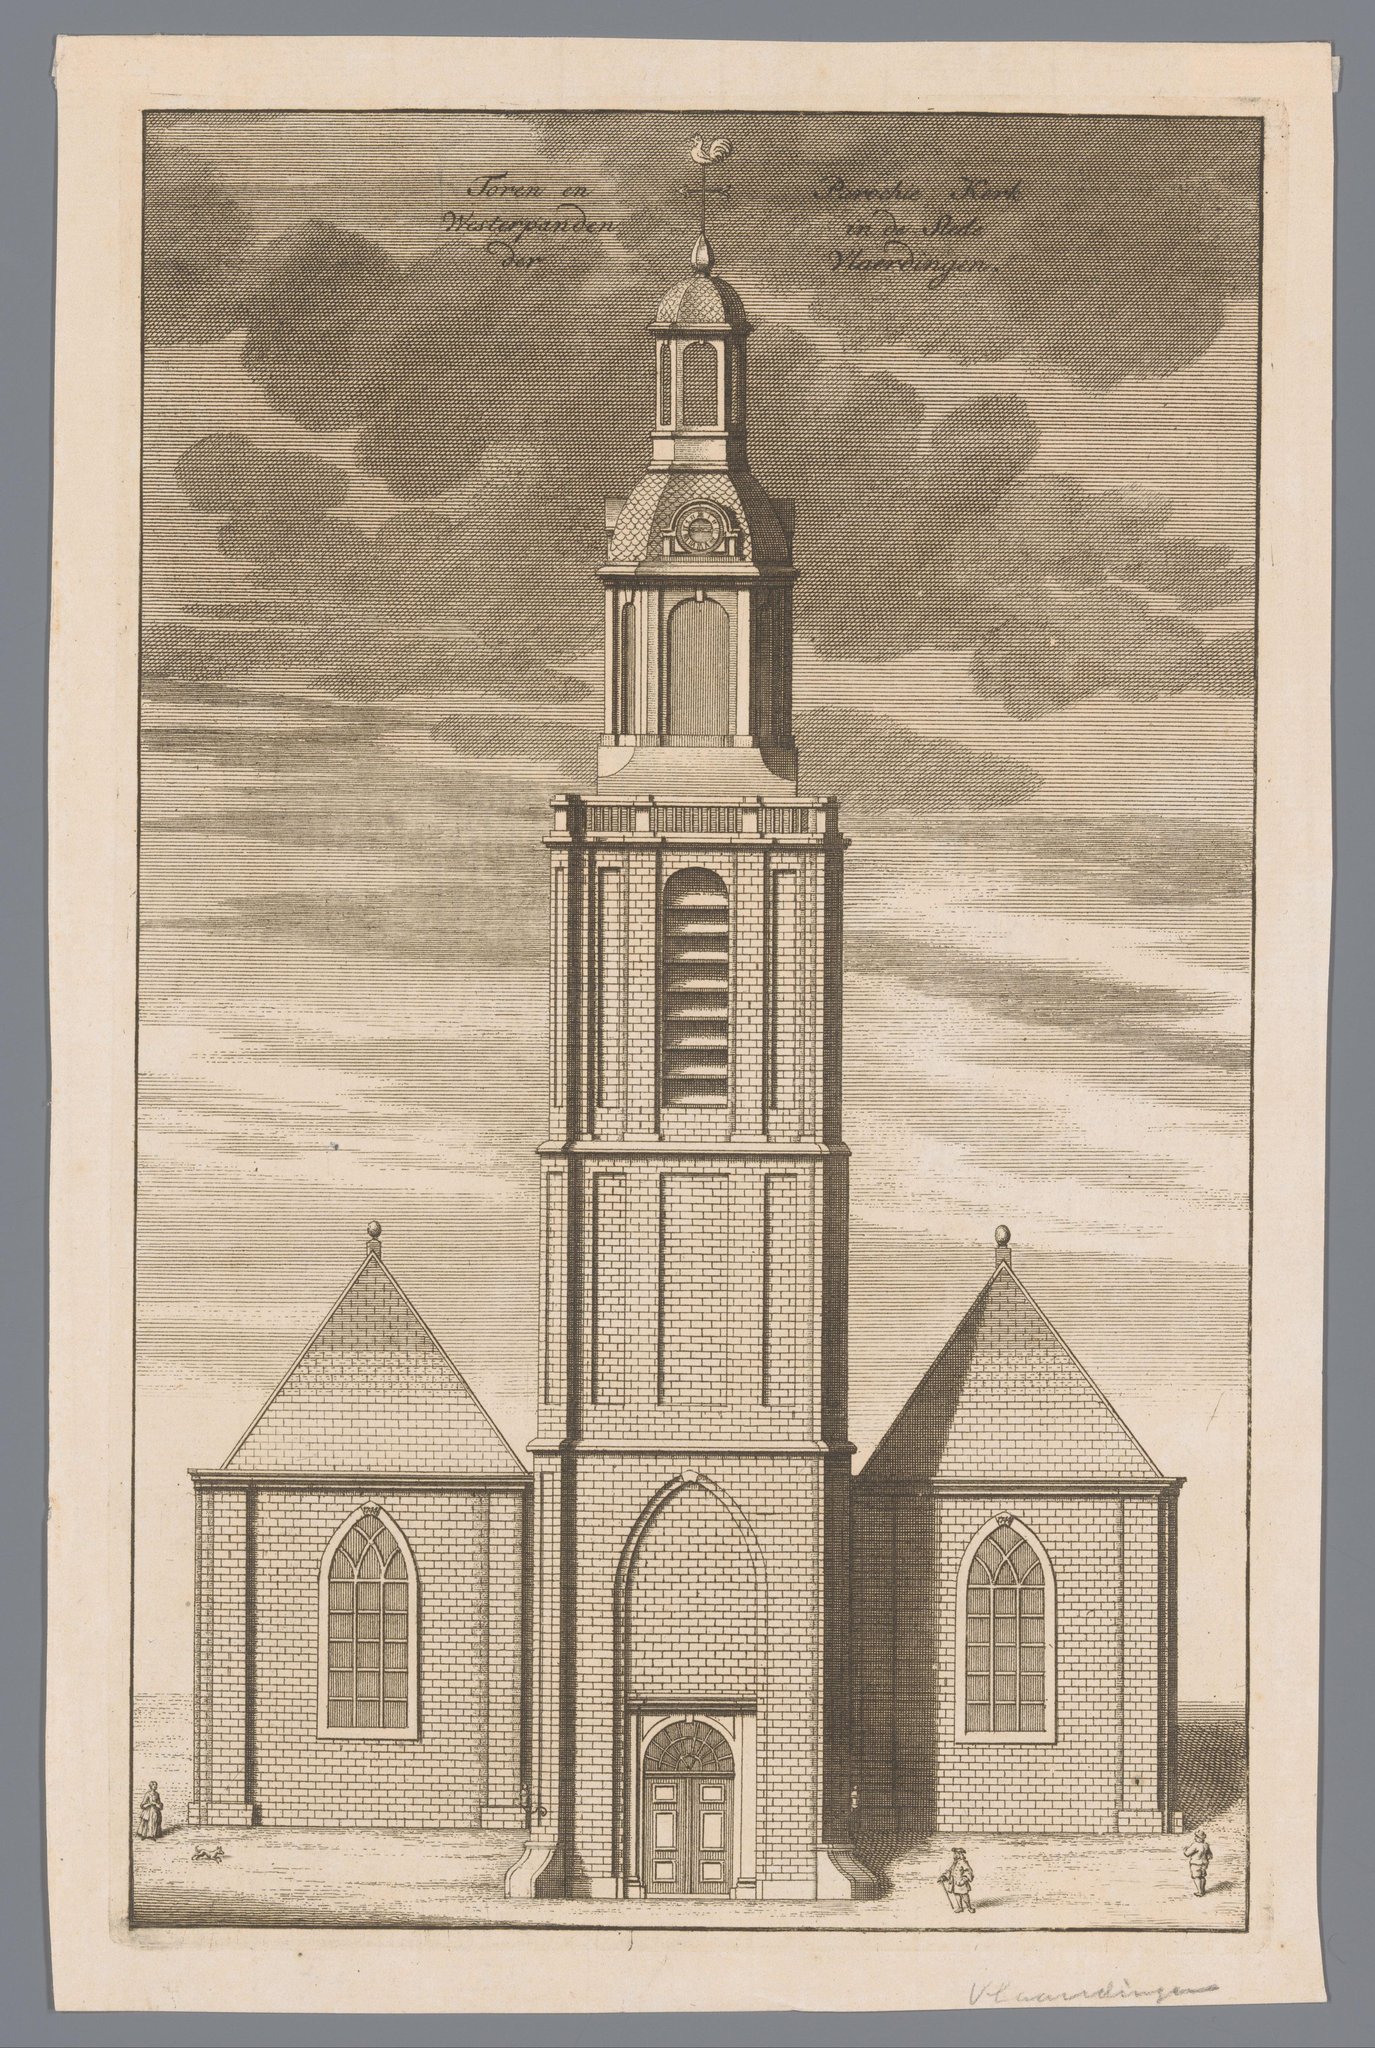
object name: print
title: Gezicht op de parochiekerk in Vlaardingen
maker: Anonymous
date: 1772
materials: paper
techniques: etching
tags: church (exterior)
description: Prent gebruikt voor: Nievelt, M.A. van. "Handvesten, octroyen, privilegien en regten, aan de stede Vlaardingen (...) vergunt of bevestigt (...). benevens eene naspeuring en aanwyzing van de ware gelegenheid, of legging, oudheid, aanzien en ongevallen derzelver Stede (...)". Den Haag: Johannes Gaillard, 1772.